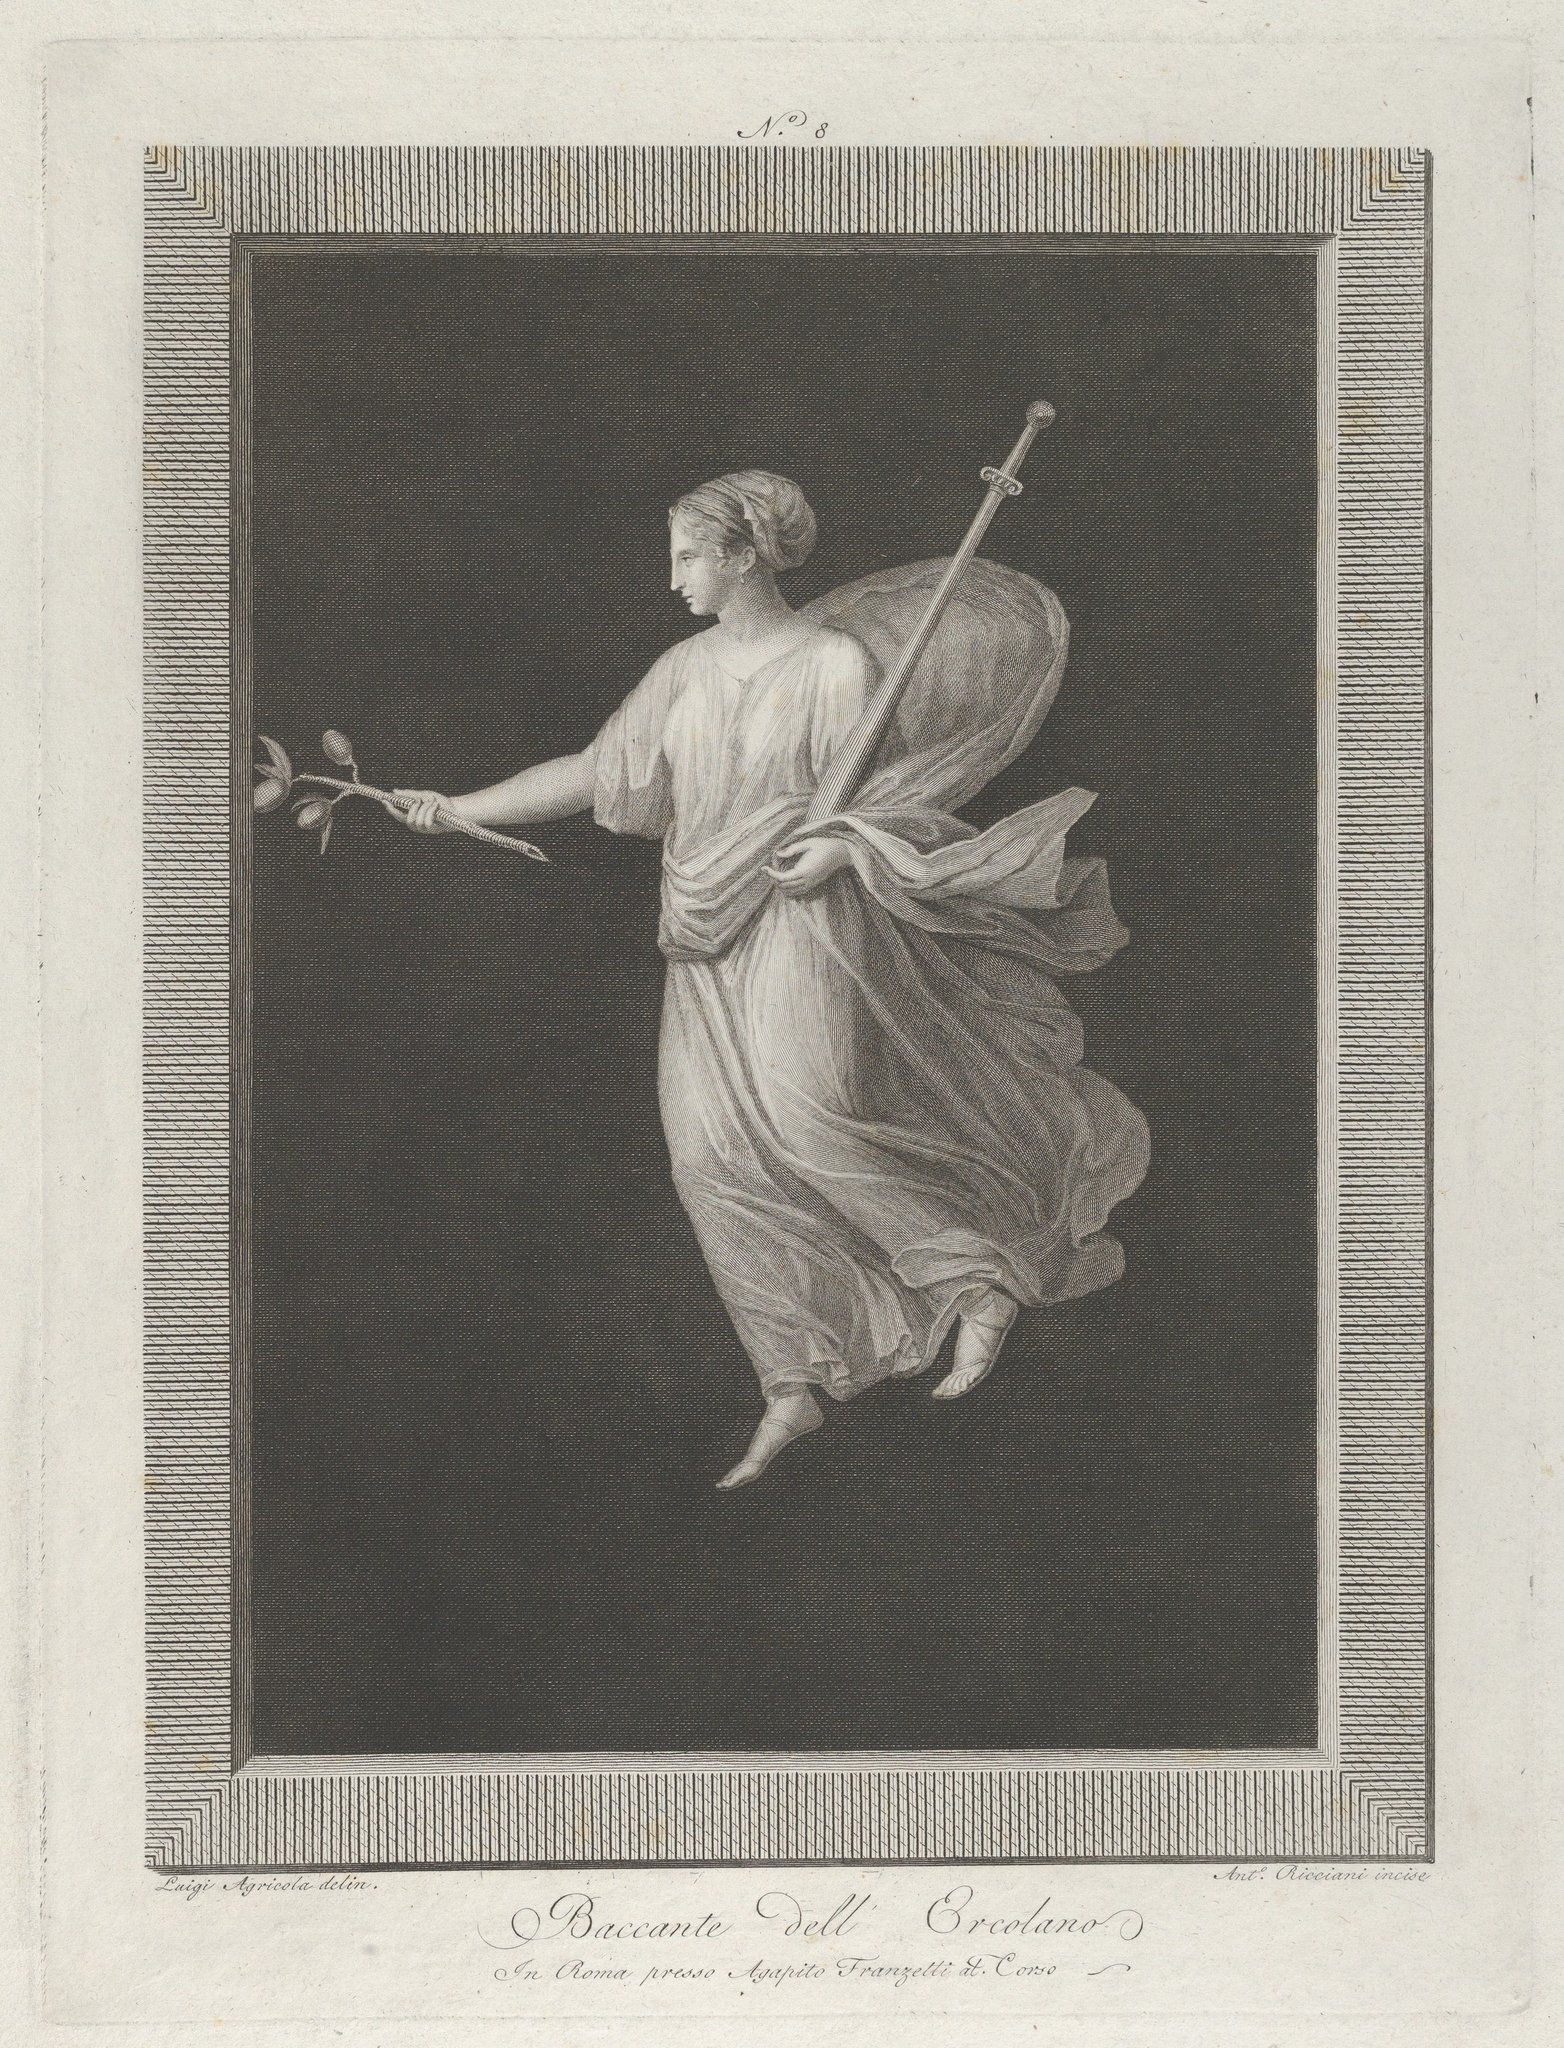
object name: print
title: A bacchante holding a sword in her left arm and a branch with fruit in her right hand, set against a black background inside a rectangular frame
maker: antonio ricciani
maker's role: artist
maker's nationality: italian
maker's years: 1775-1847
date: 1795-1820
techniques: engraving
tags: swords,fruit,bacchantes